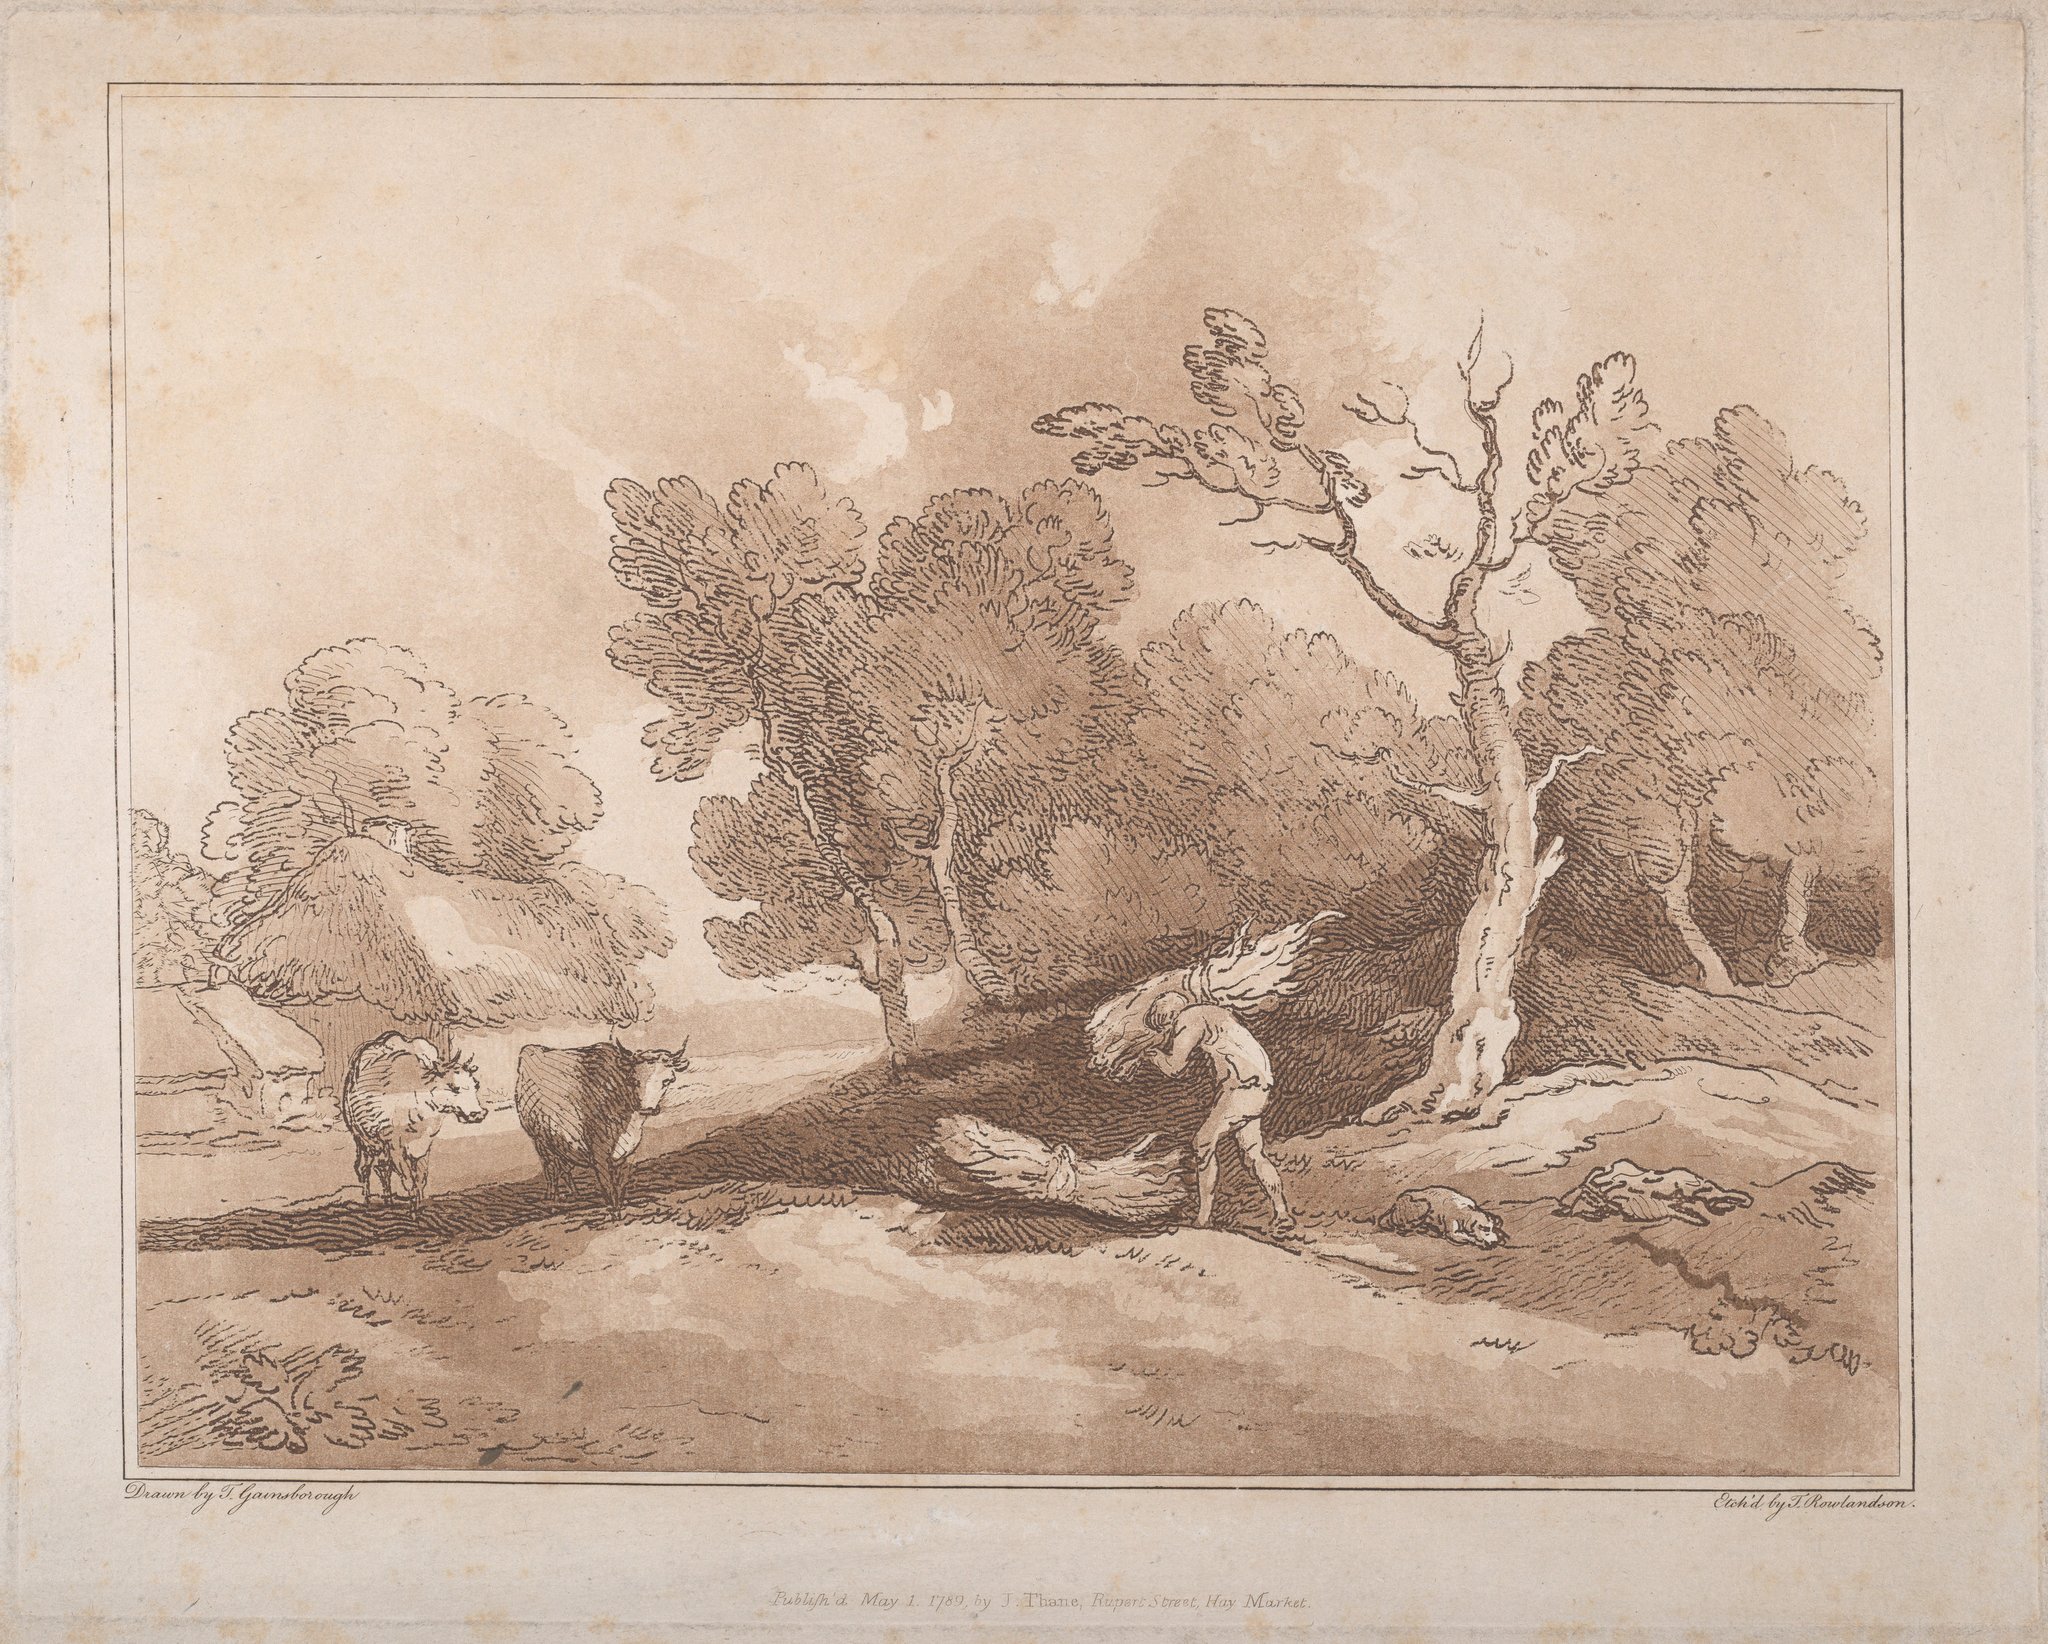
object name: print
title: Landscape with a Figure Carrying a Bundle of Branches, a Copice Behind, Two Cows in a Field at Left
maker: thomas rowlandson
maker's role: artist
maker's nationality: british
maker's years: 1757-1827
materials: ink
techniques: aquatint, etching, printing